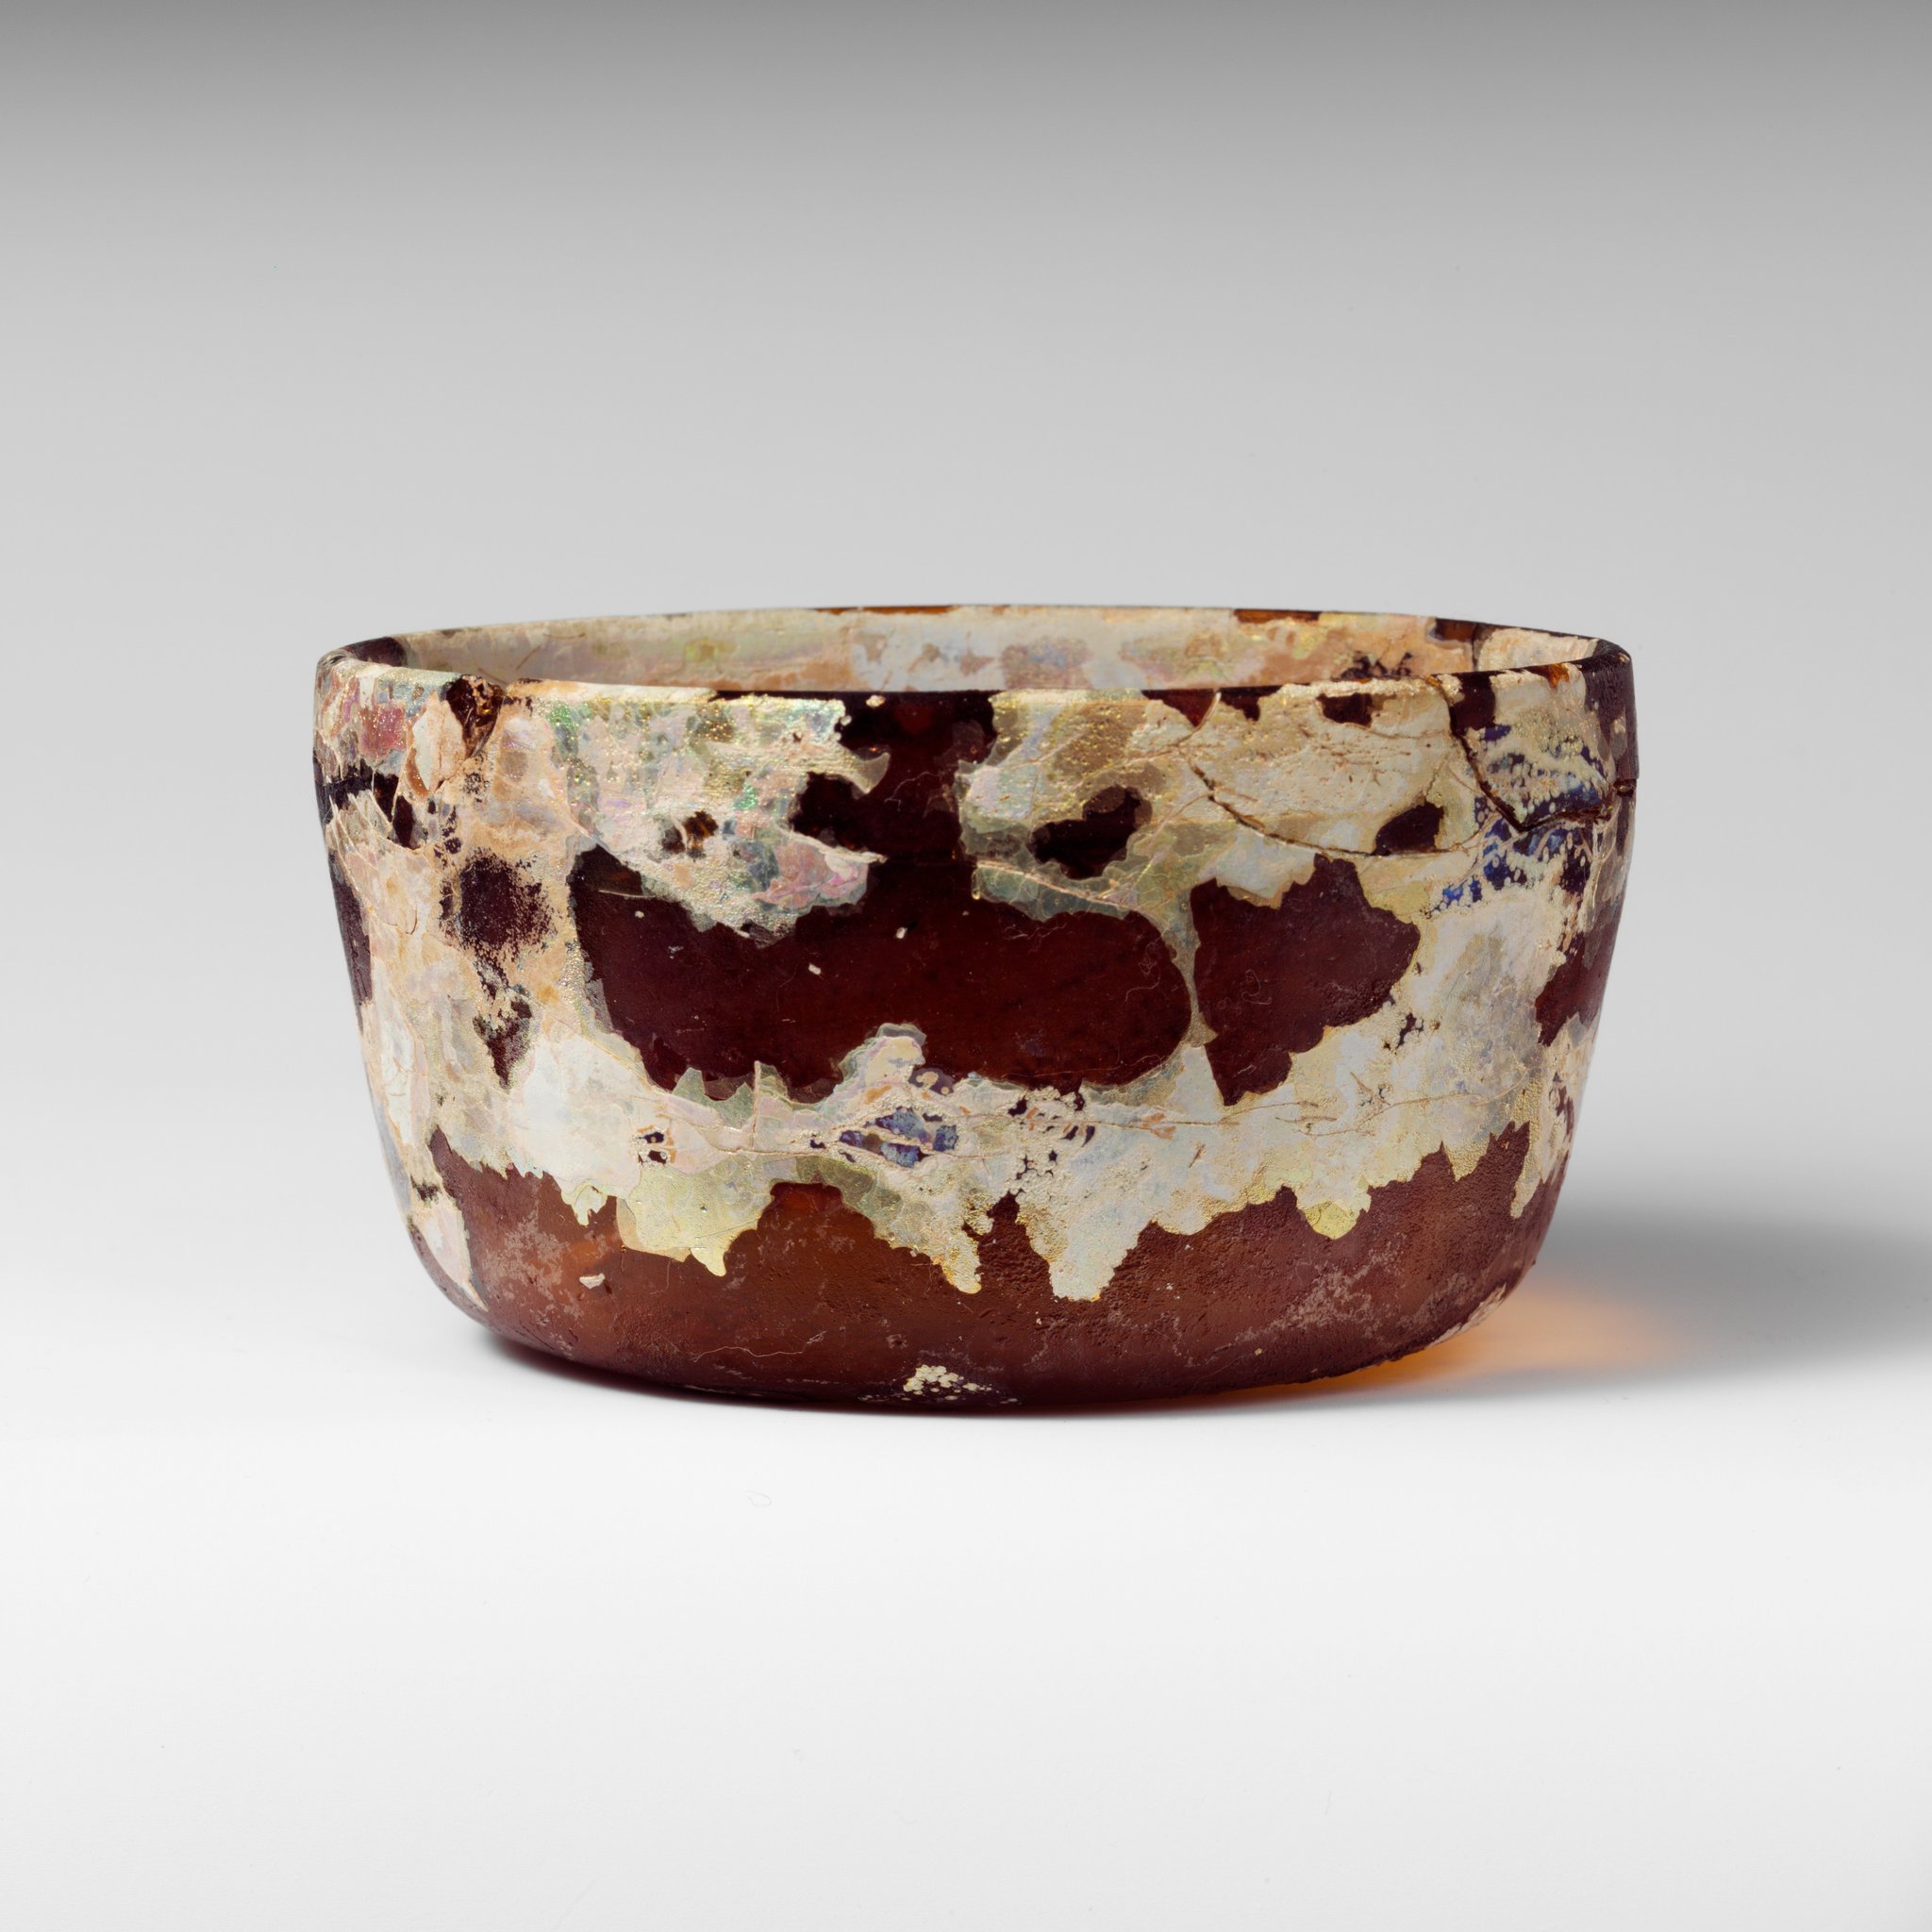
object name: bowl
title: Glass bowl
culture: roman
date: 34 BCE-33 CE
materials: glass